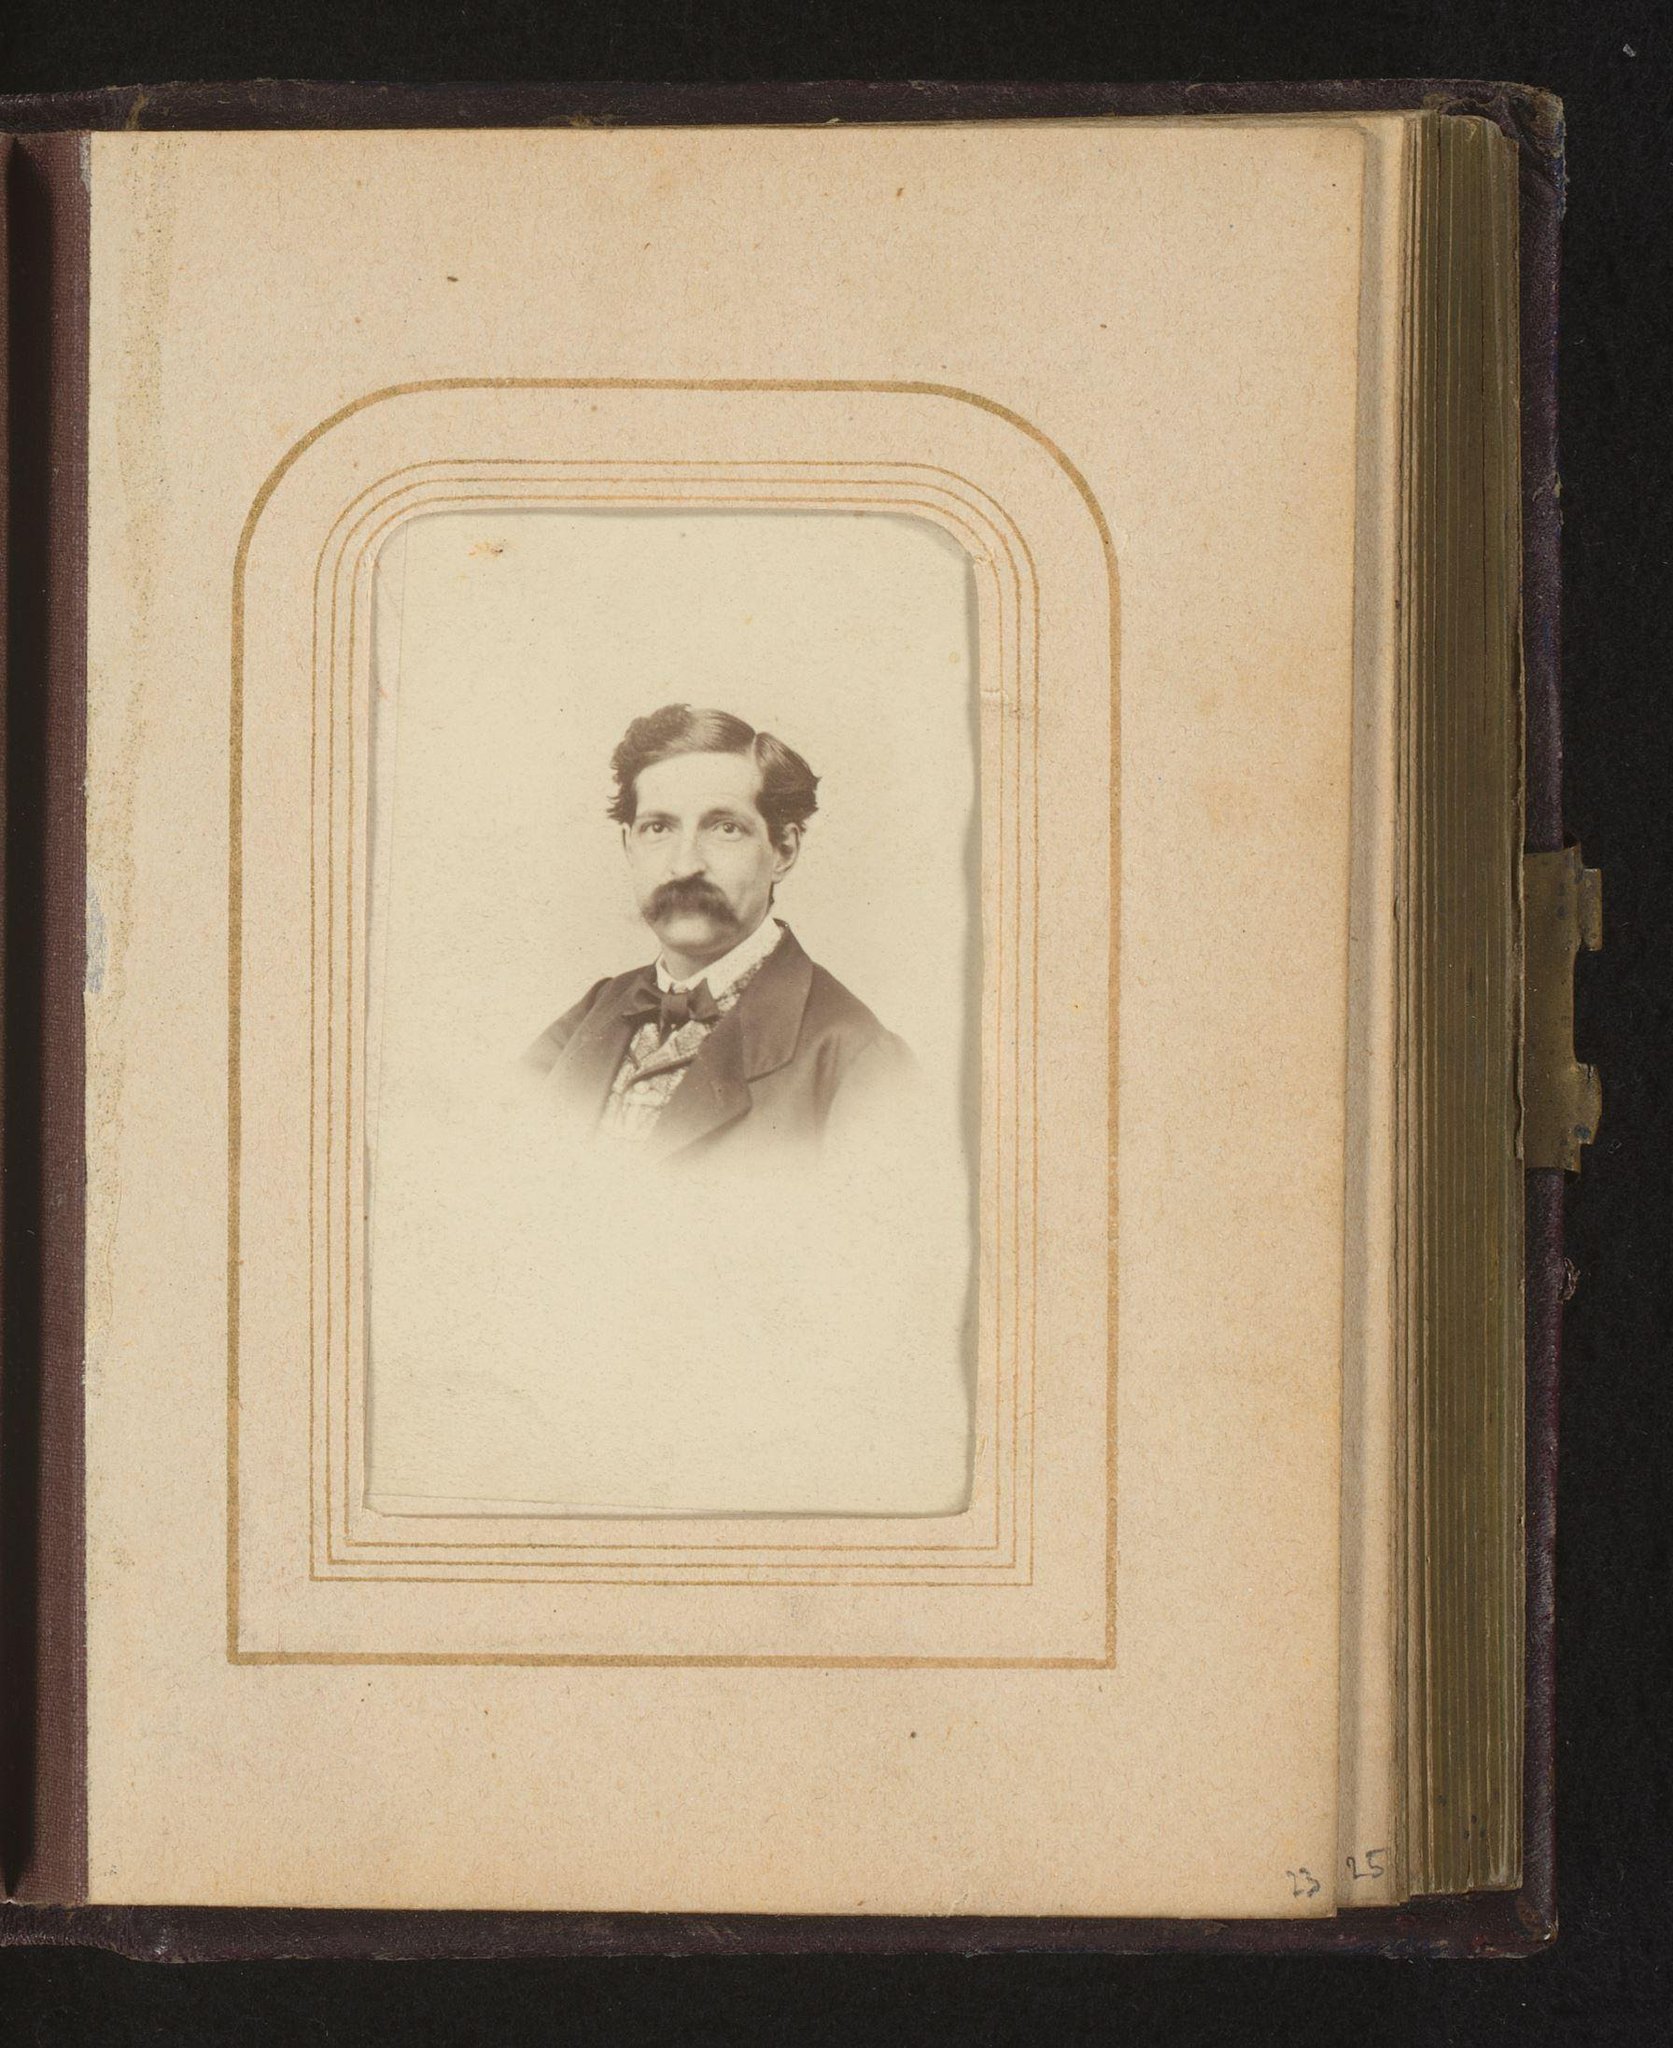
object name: photograph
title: Portret van een man met snor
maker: Anonymous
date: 1860-1900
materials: cardboard, photographic support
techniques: albumen print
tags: moustache, historical persons